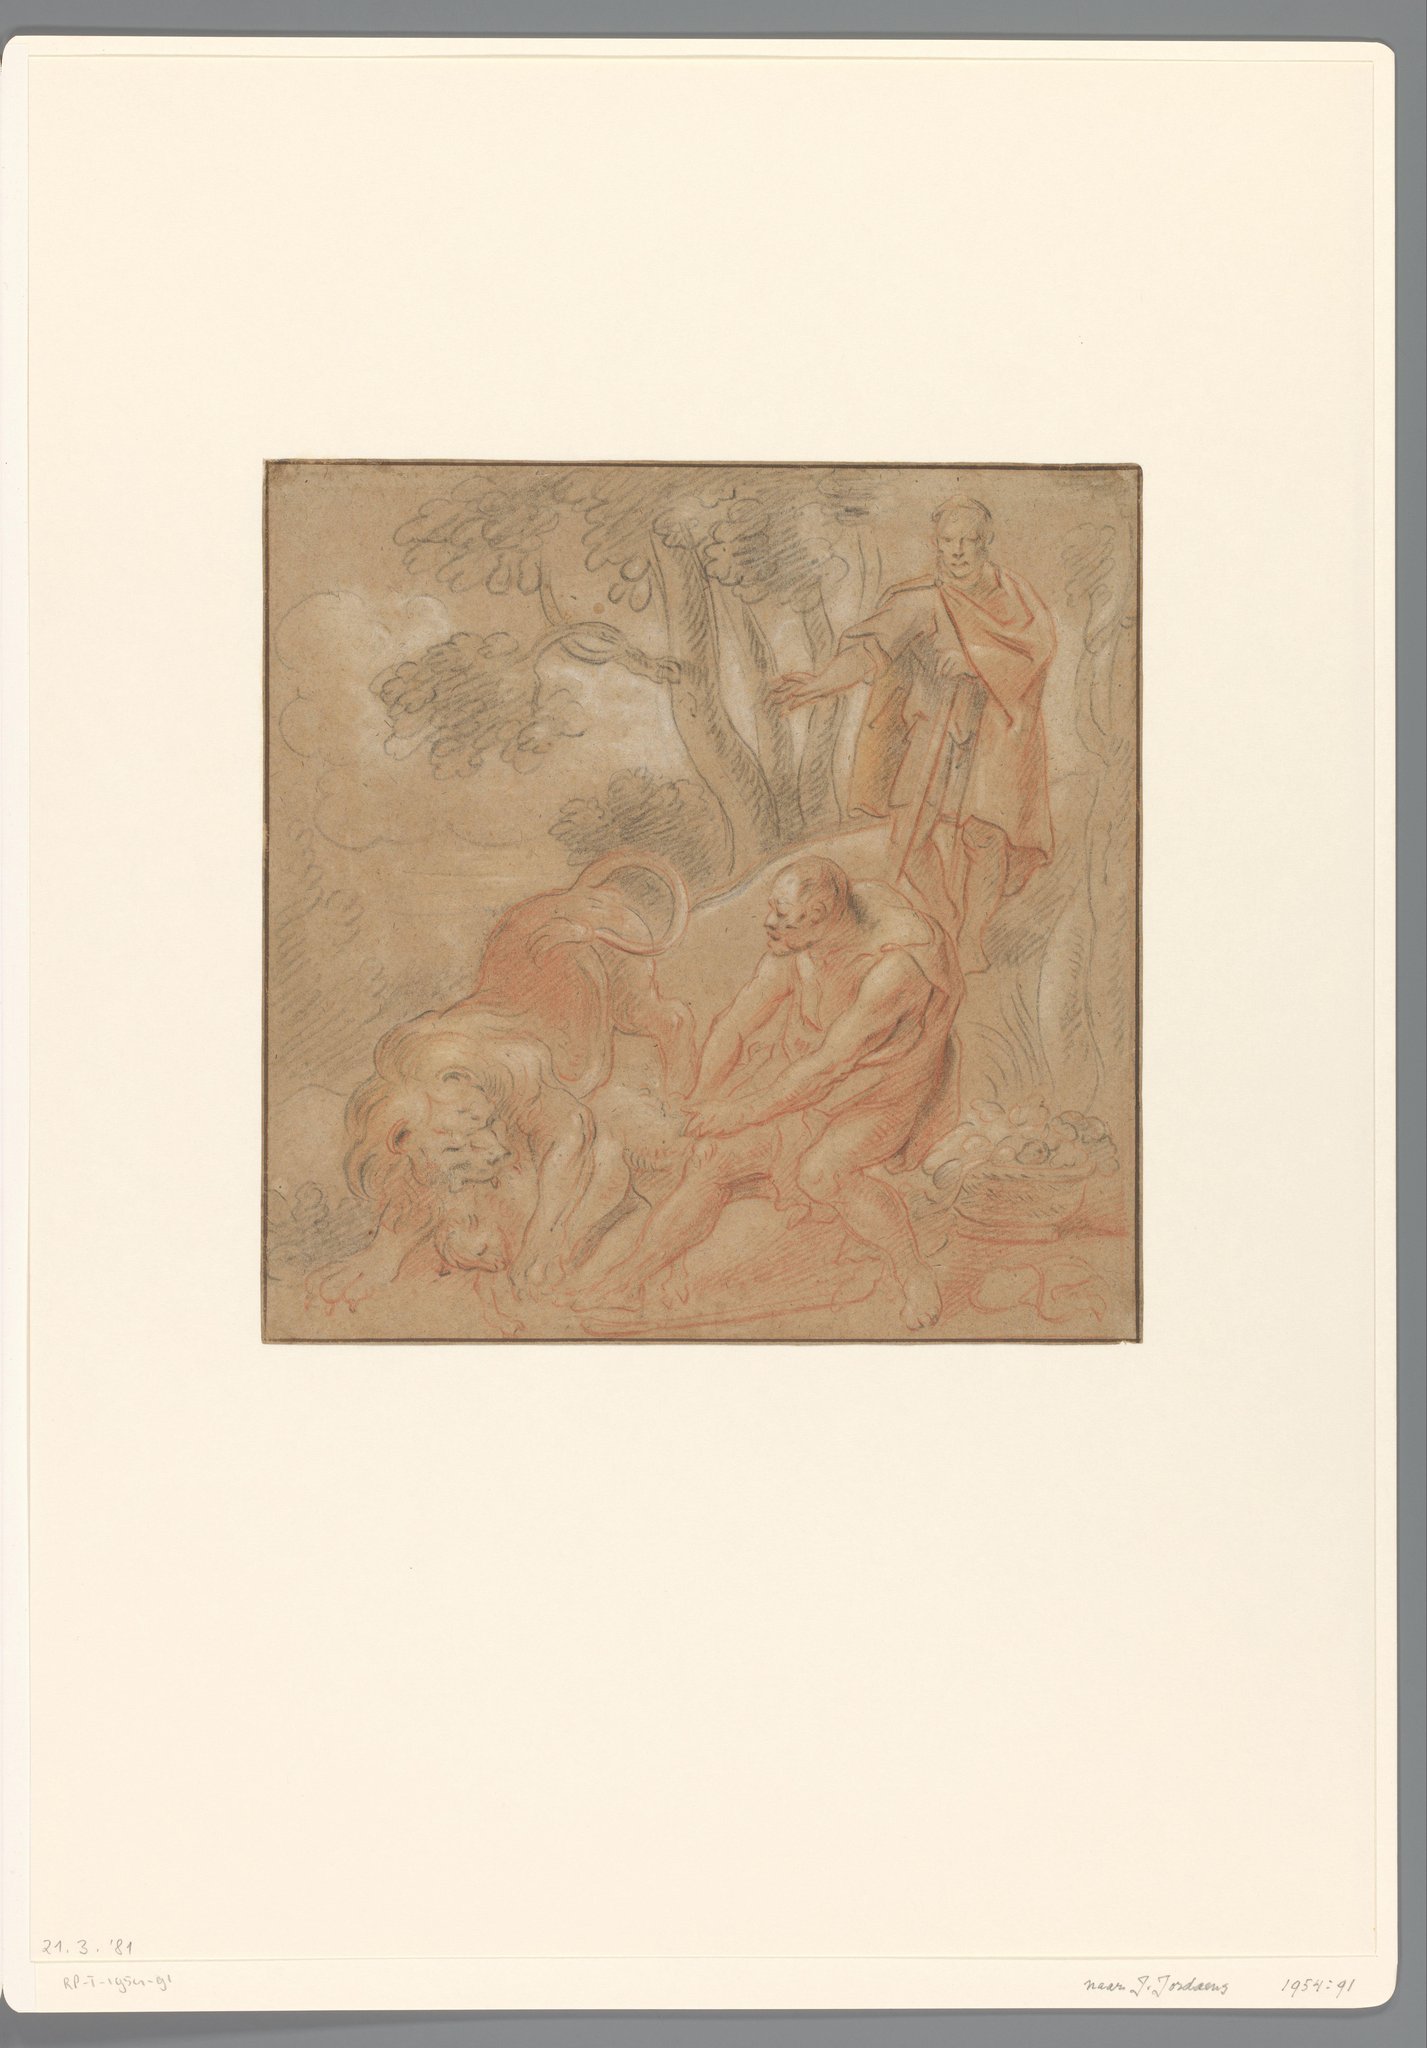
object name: drawing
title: De profetieën van Amos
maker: Anonymous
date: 1603-1728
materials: chalk, paper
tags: other prophecies of destruction ~ the book of amos, amos' visions (amos 7 - 9:8)